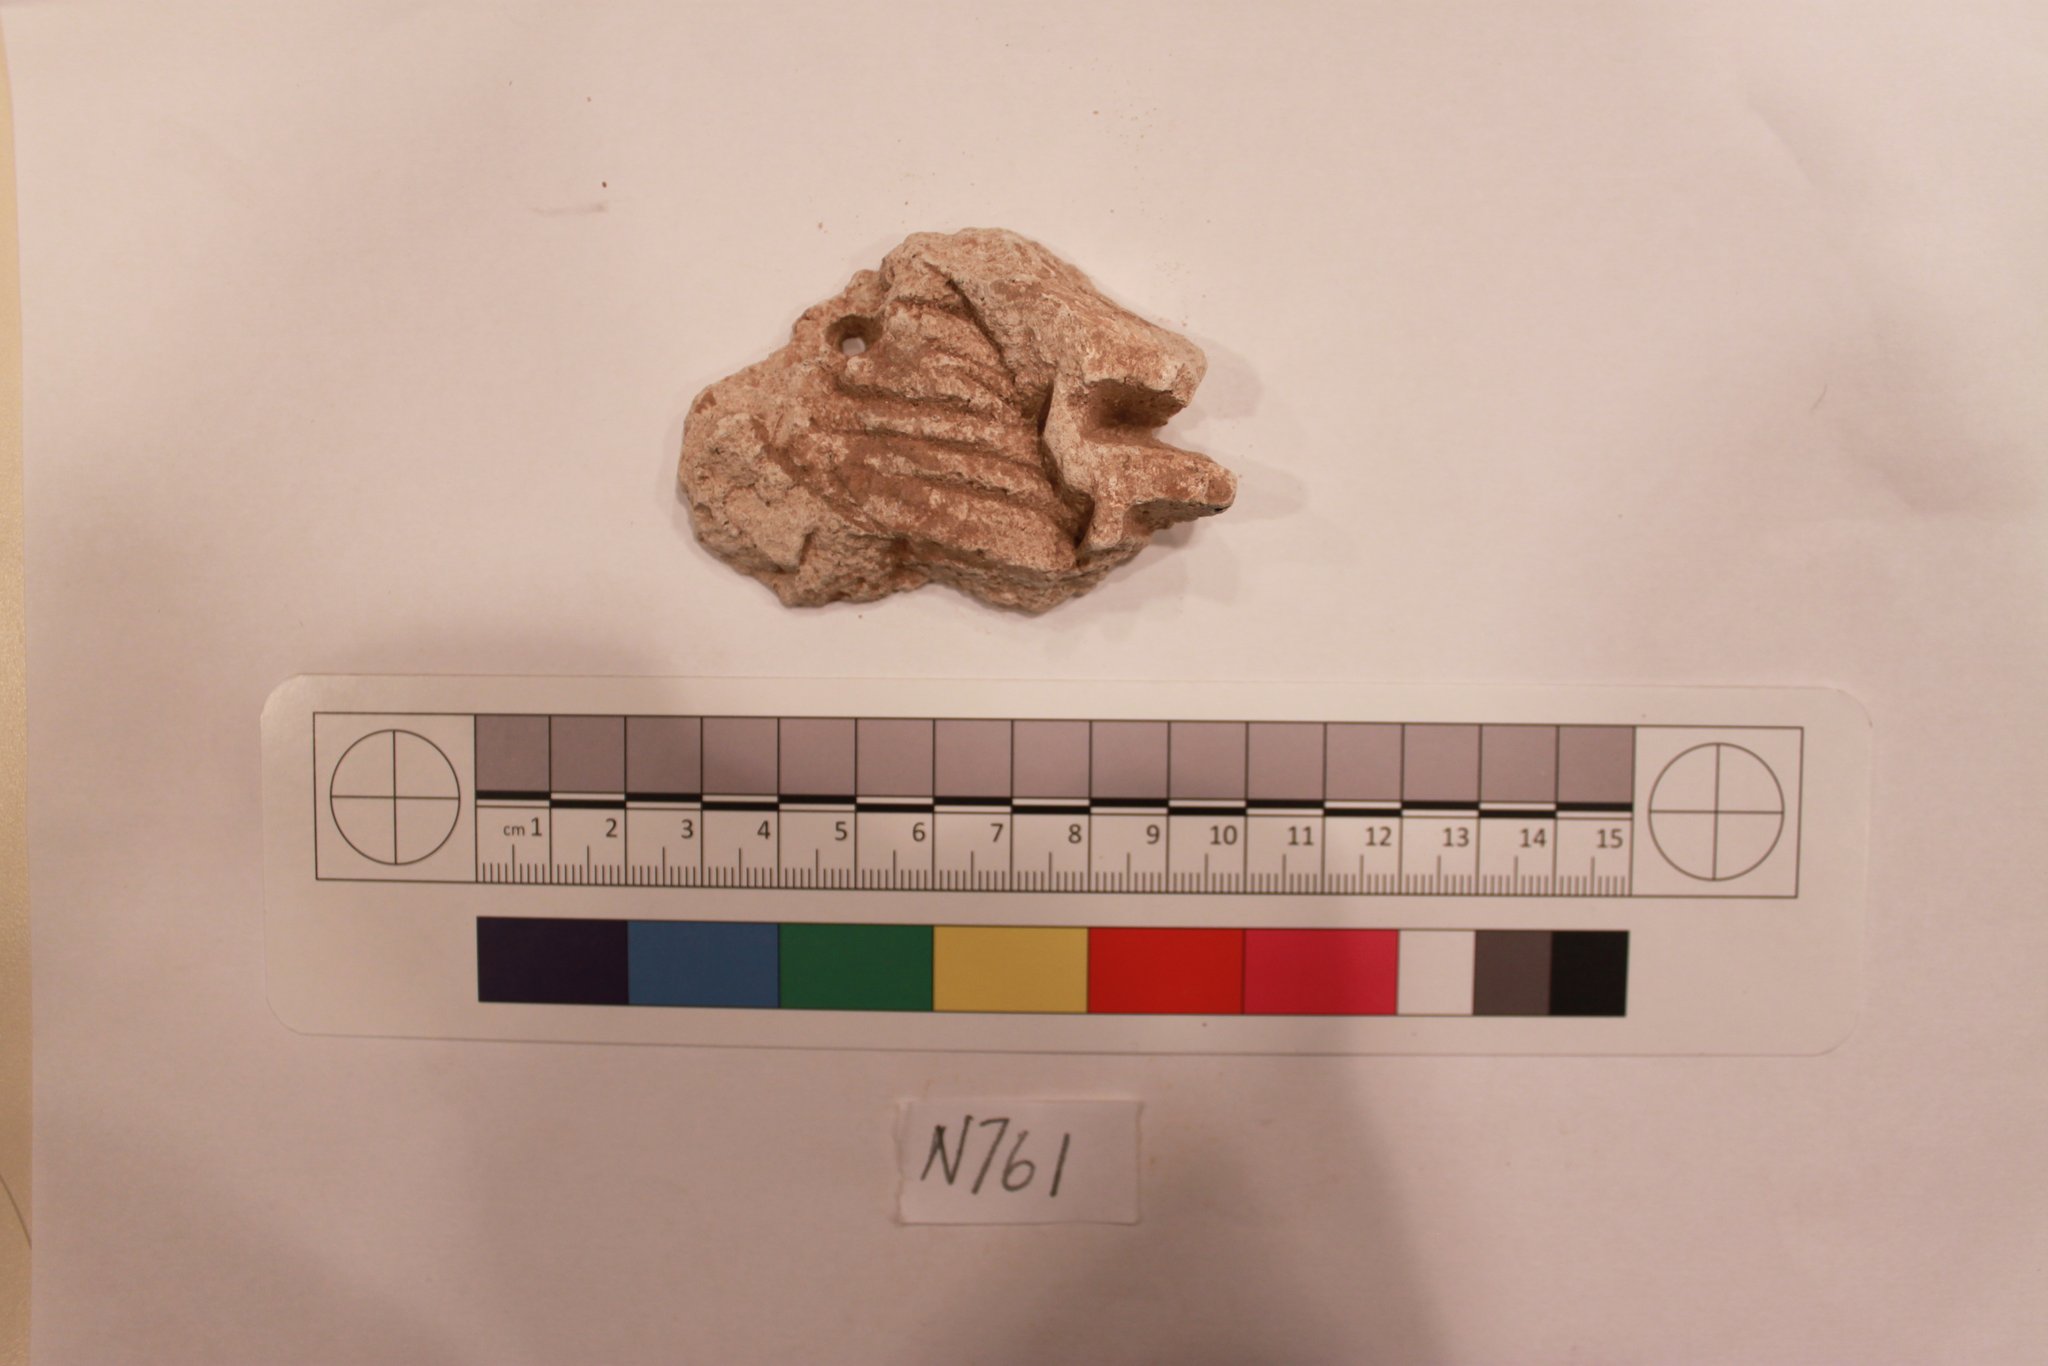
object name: fragment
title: Stucco Fragment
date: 701-1200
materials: plaster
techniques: carving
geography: iran